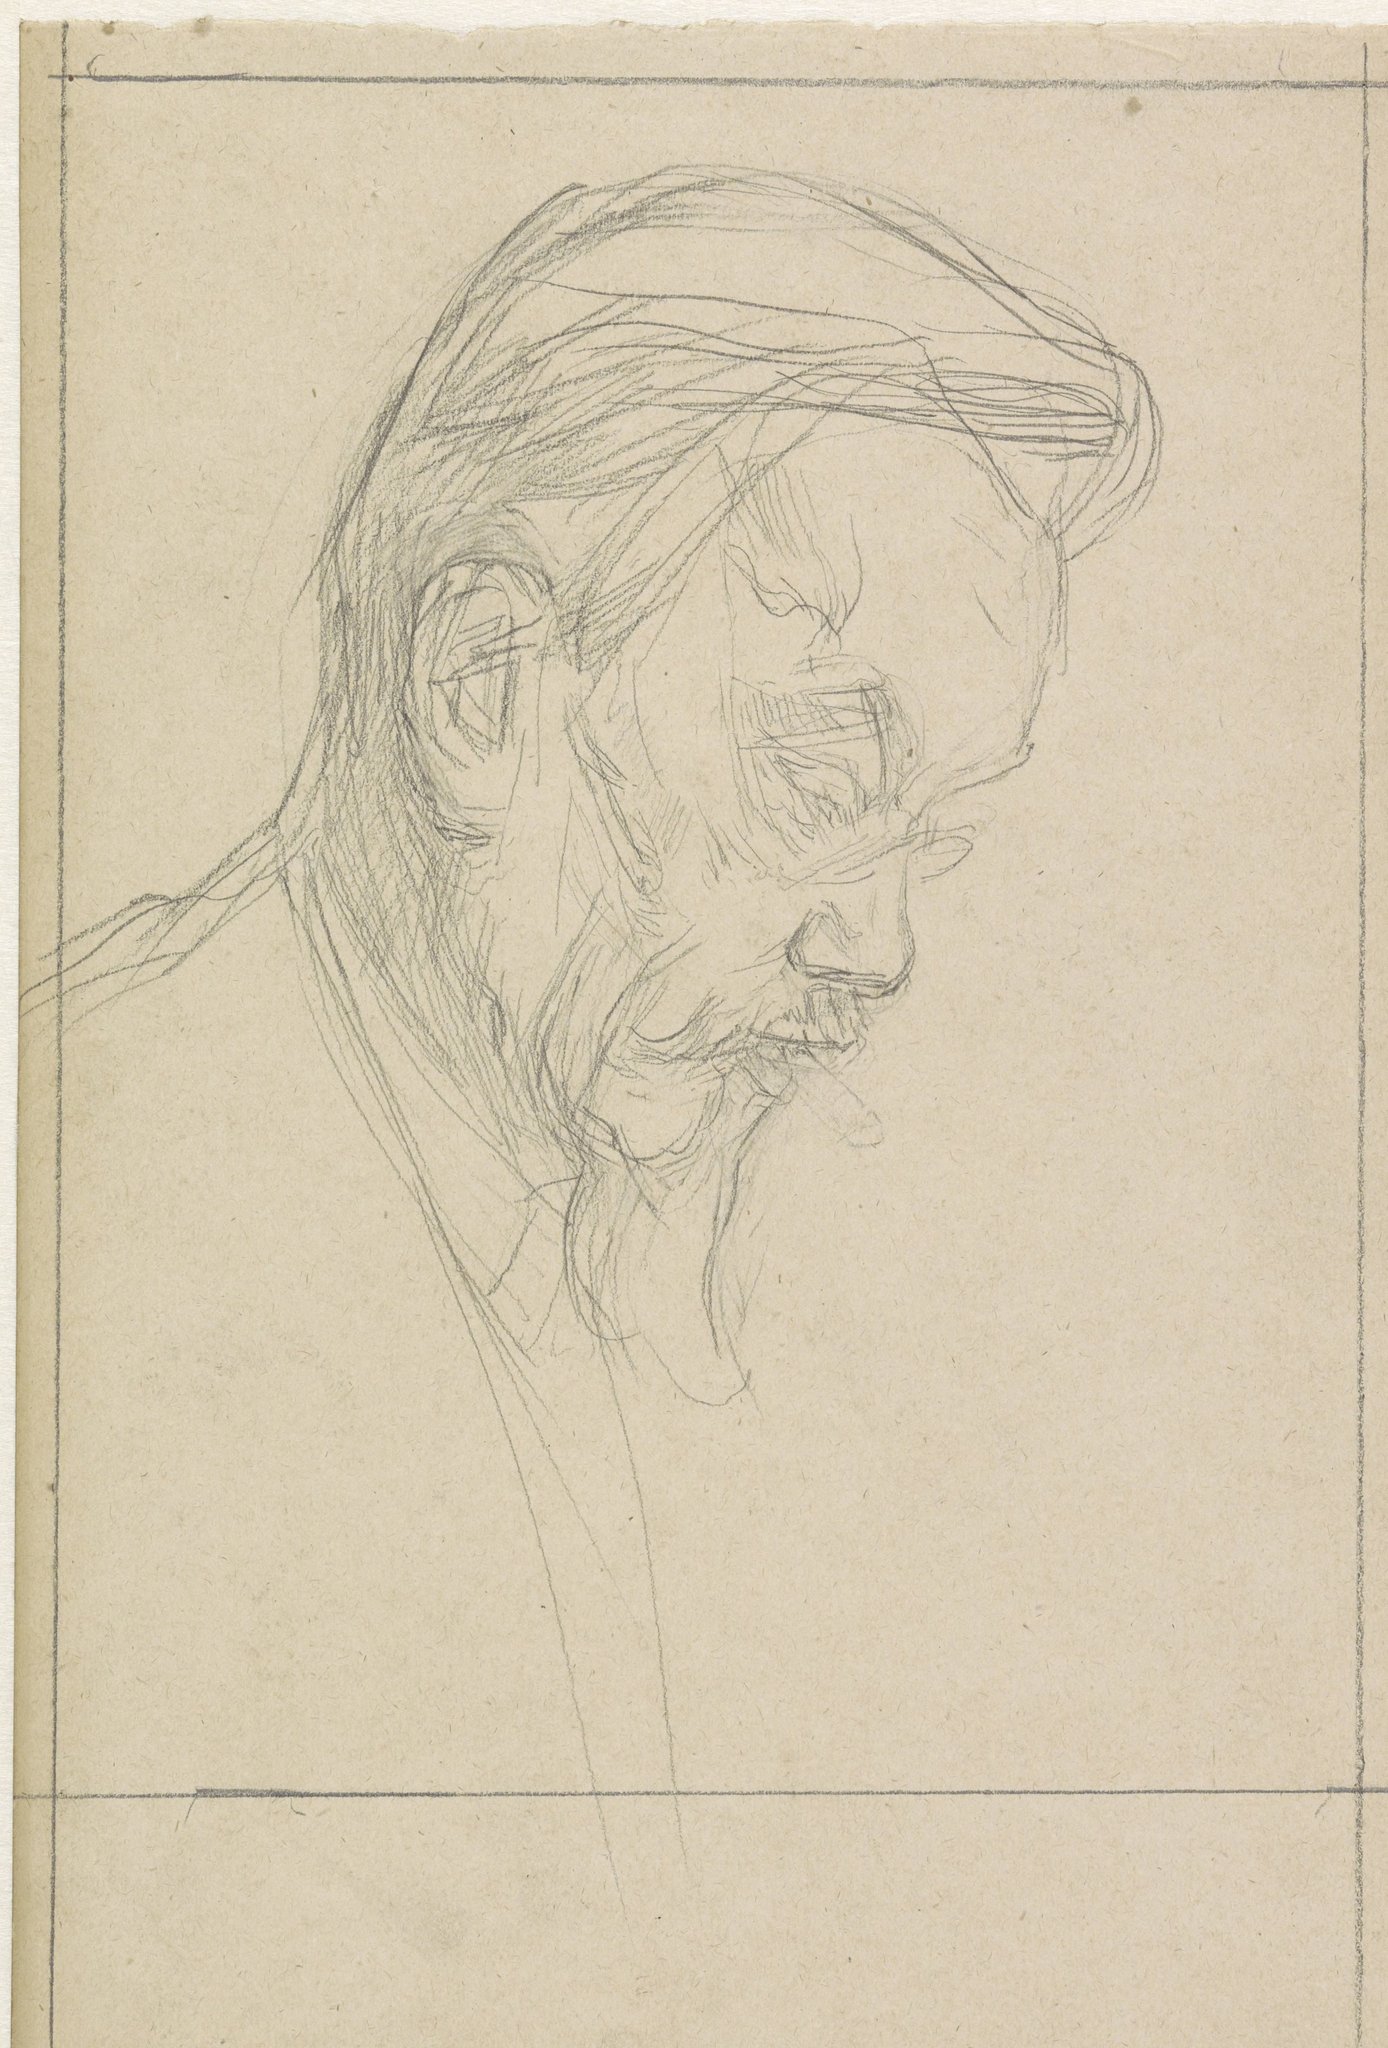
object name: drawing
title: Portret van Cornelis Hofstede de Groot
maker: jan veth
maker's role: designer, draughtsman, painter, print maker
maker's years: 1864-1925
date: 1874-1925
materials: paper, pencil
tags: the hague, cornelis hofstede de groot, historical persons